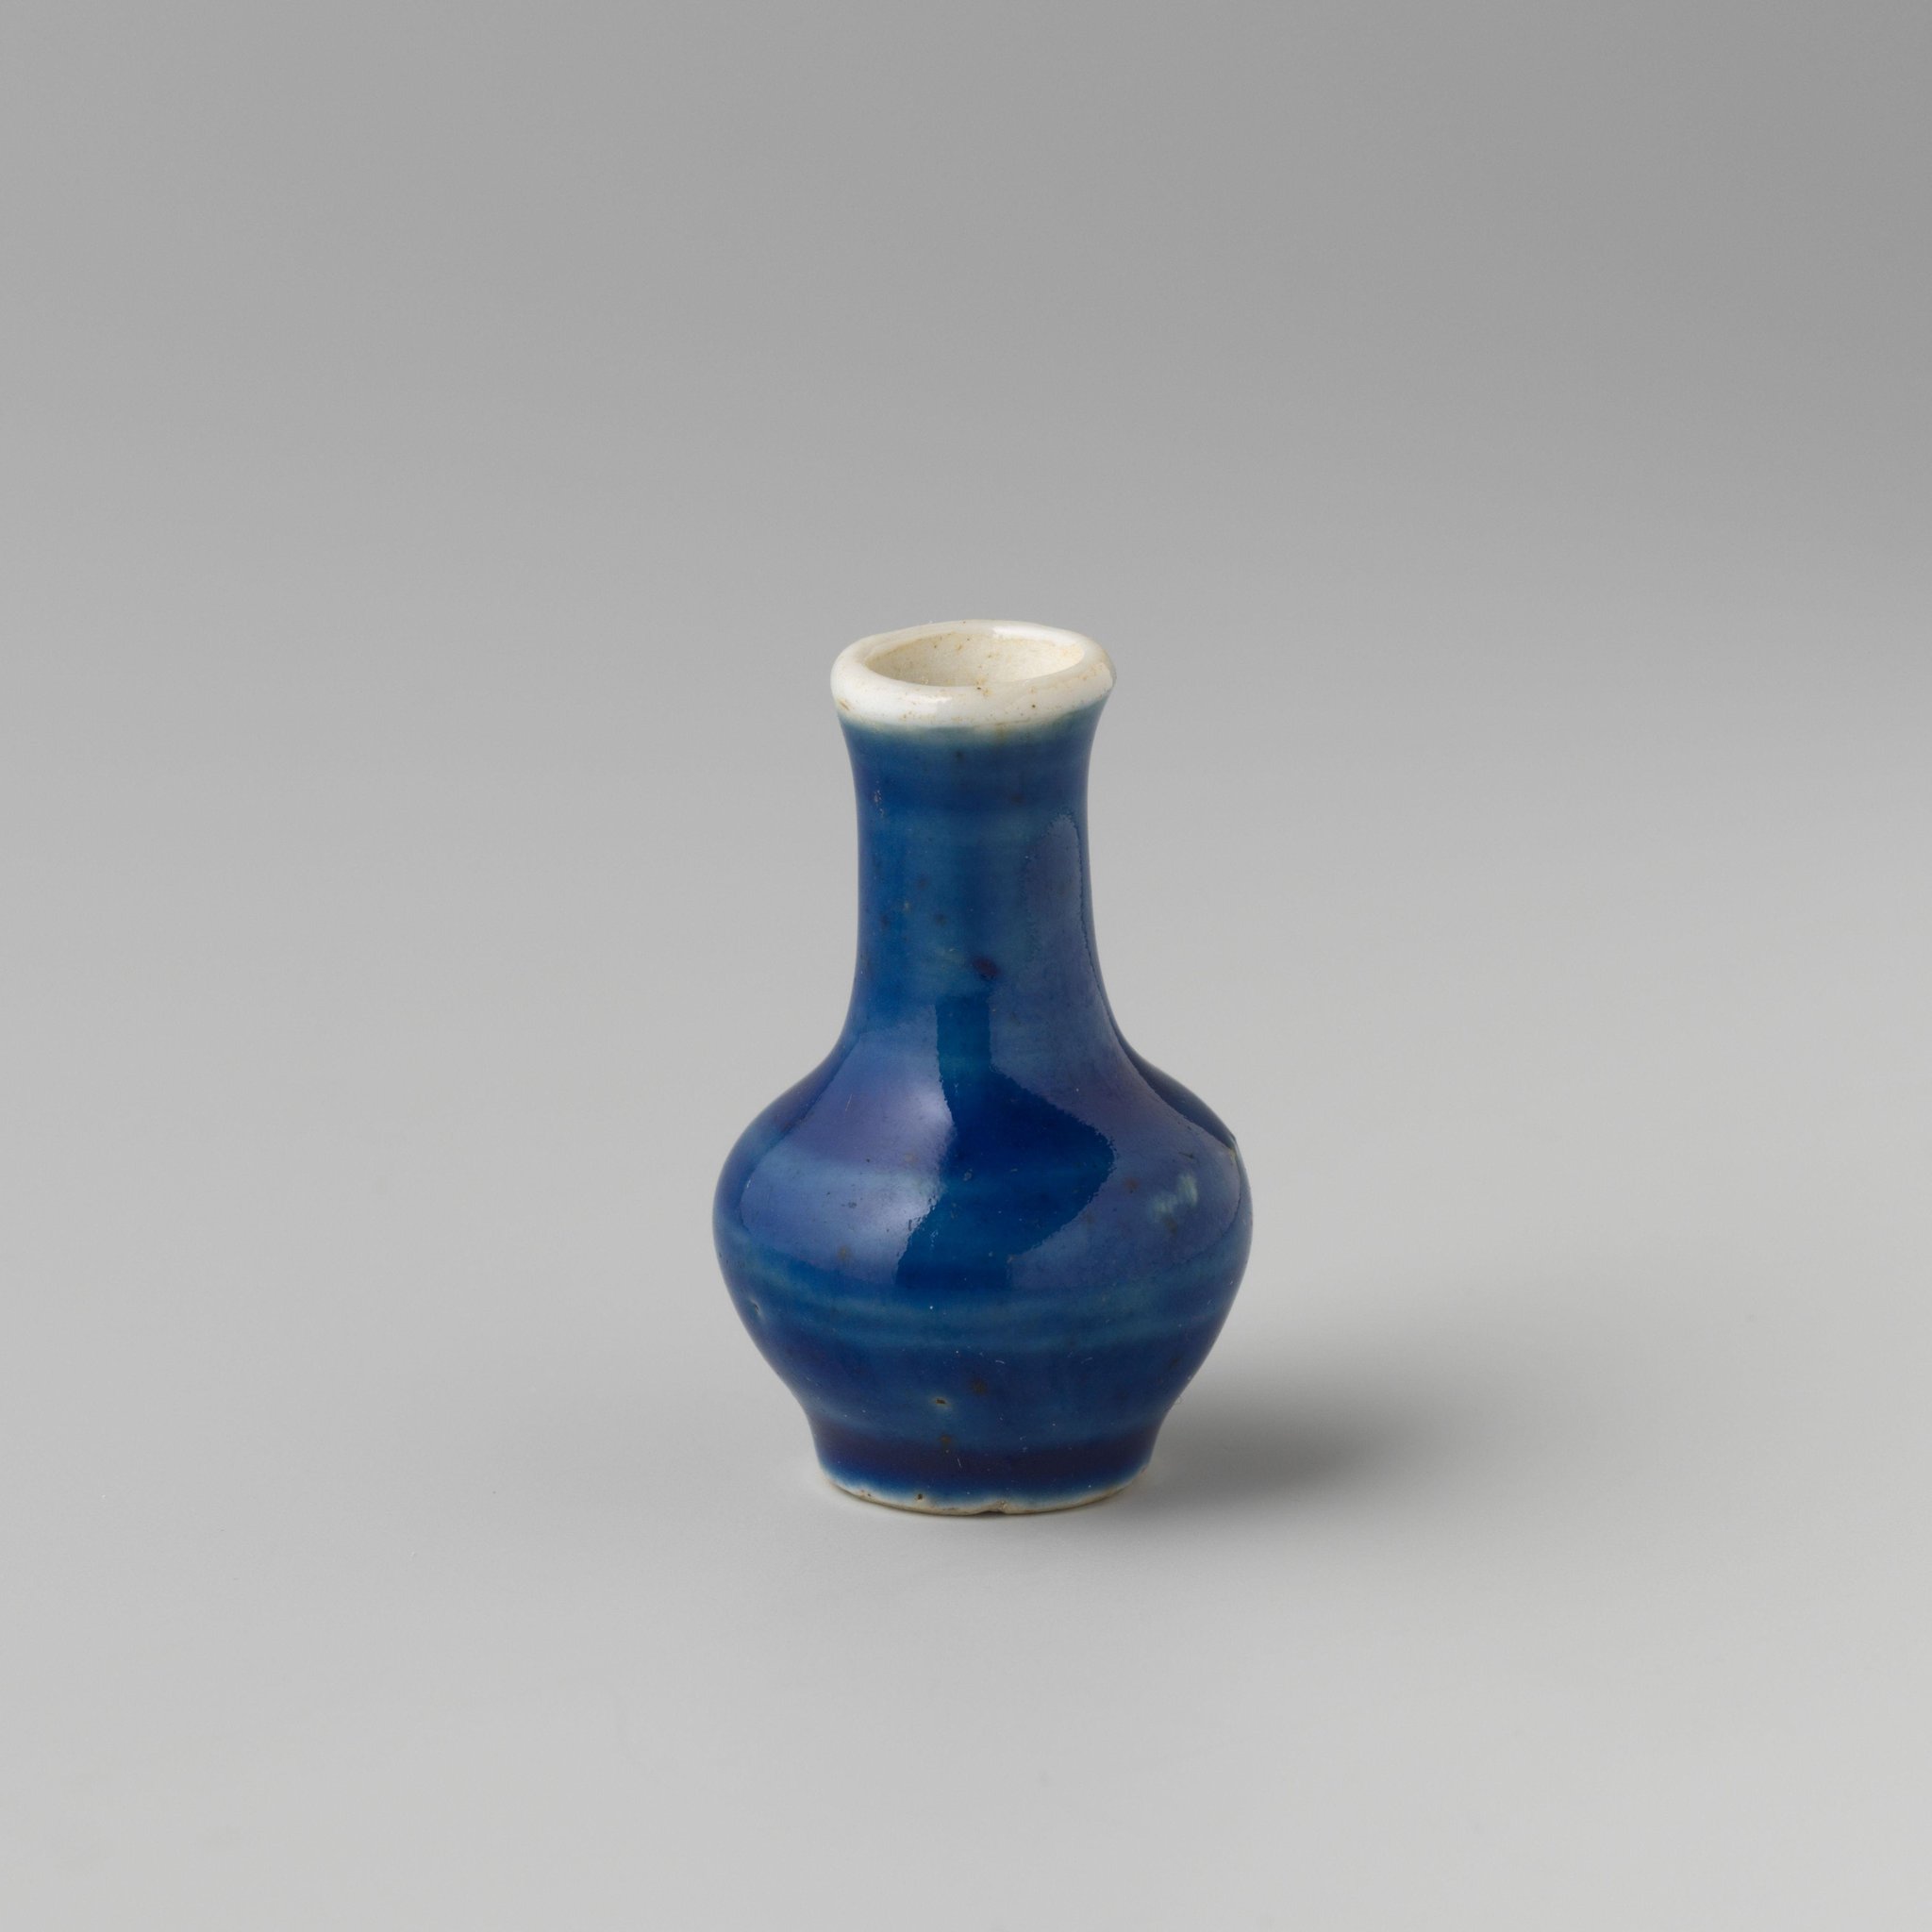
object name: vase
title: Miniature bottle vase with a blue glaze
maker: Anonymous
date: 1700-1740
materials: cobalt, glaze, porcelain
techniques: firing, turning, vitrification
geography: china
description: Vaas van porselein, onderglazuur monochroom blauw met witte bovenrand, eivormig met hoge hals, op standring.